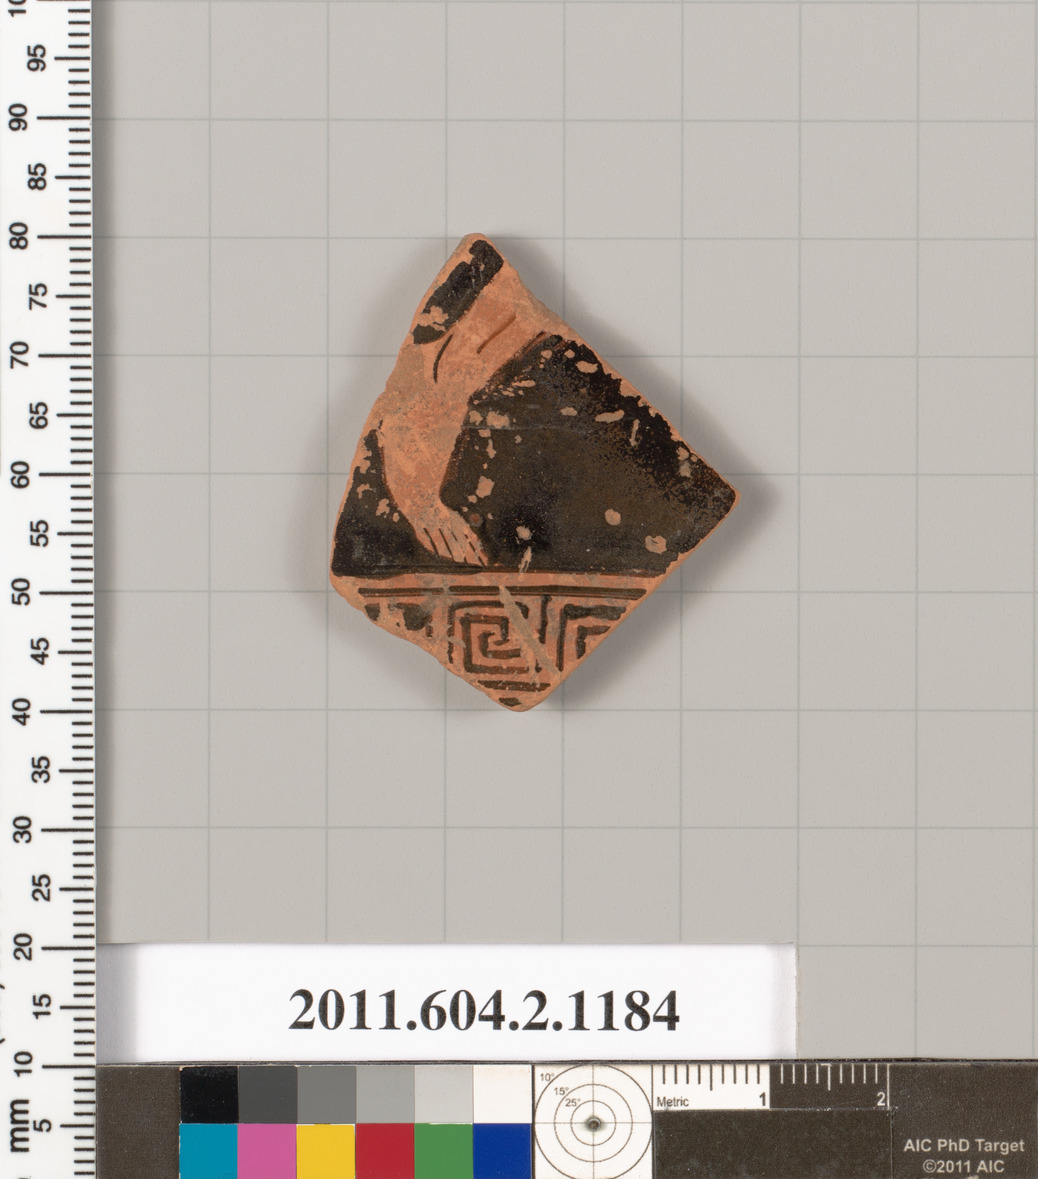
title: Terracotta fragment of a small, closed shape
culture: greek, attic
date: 450-426 BCE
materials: terracotta